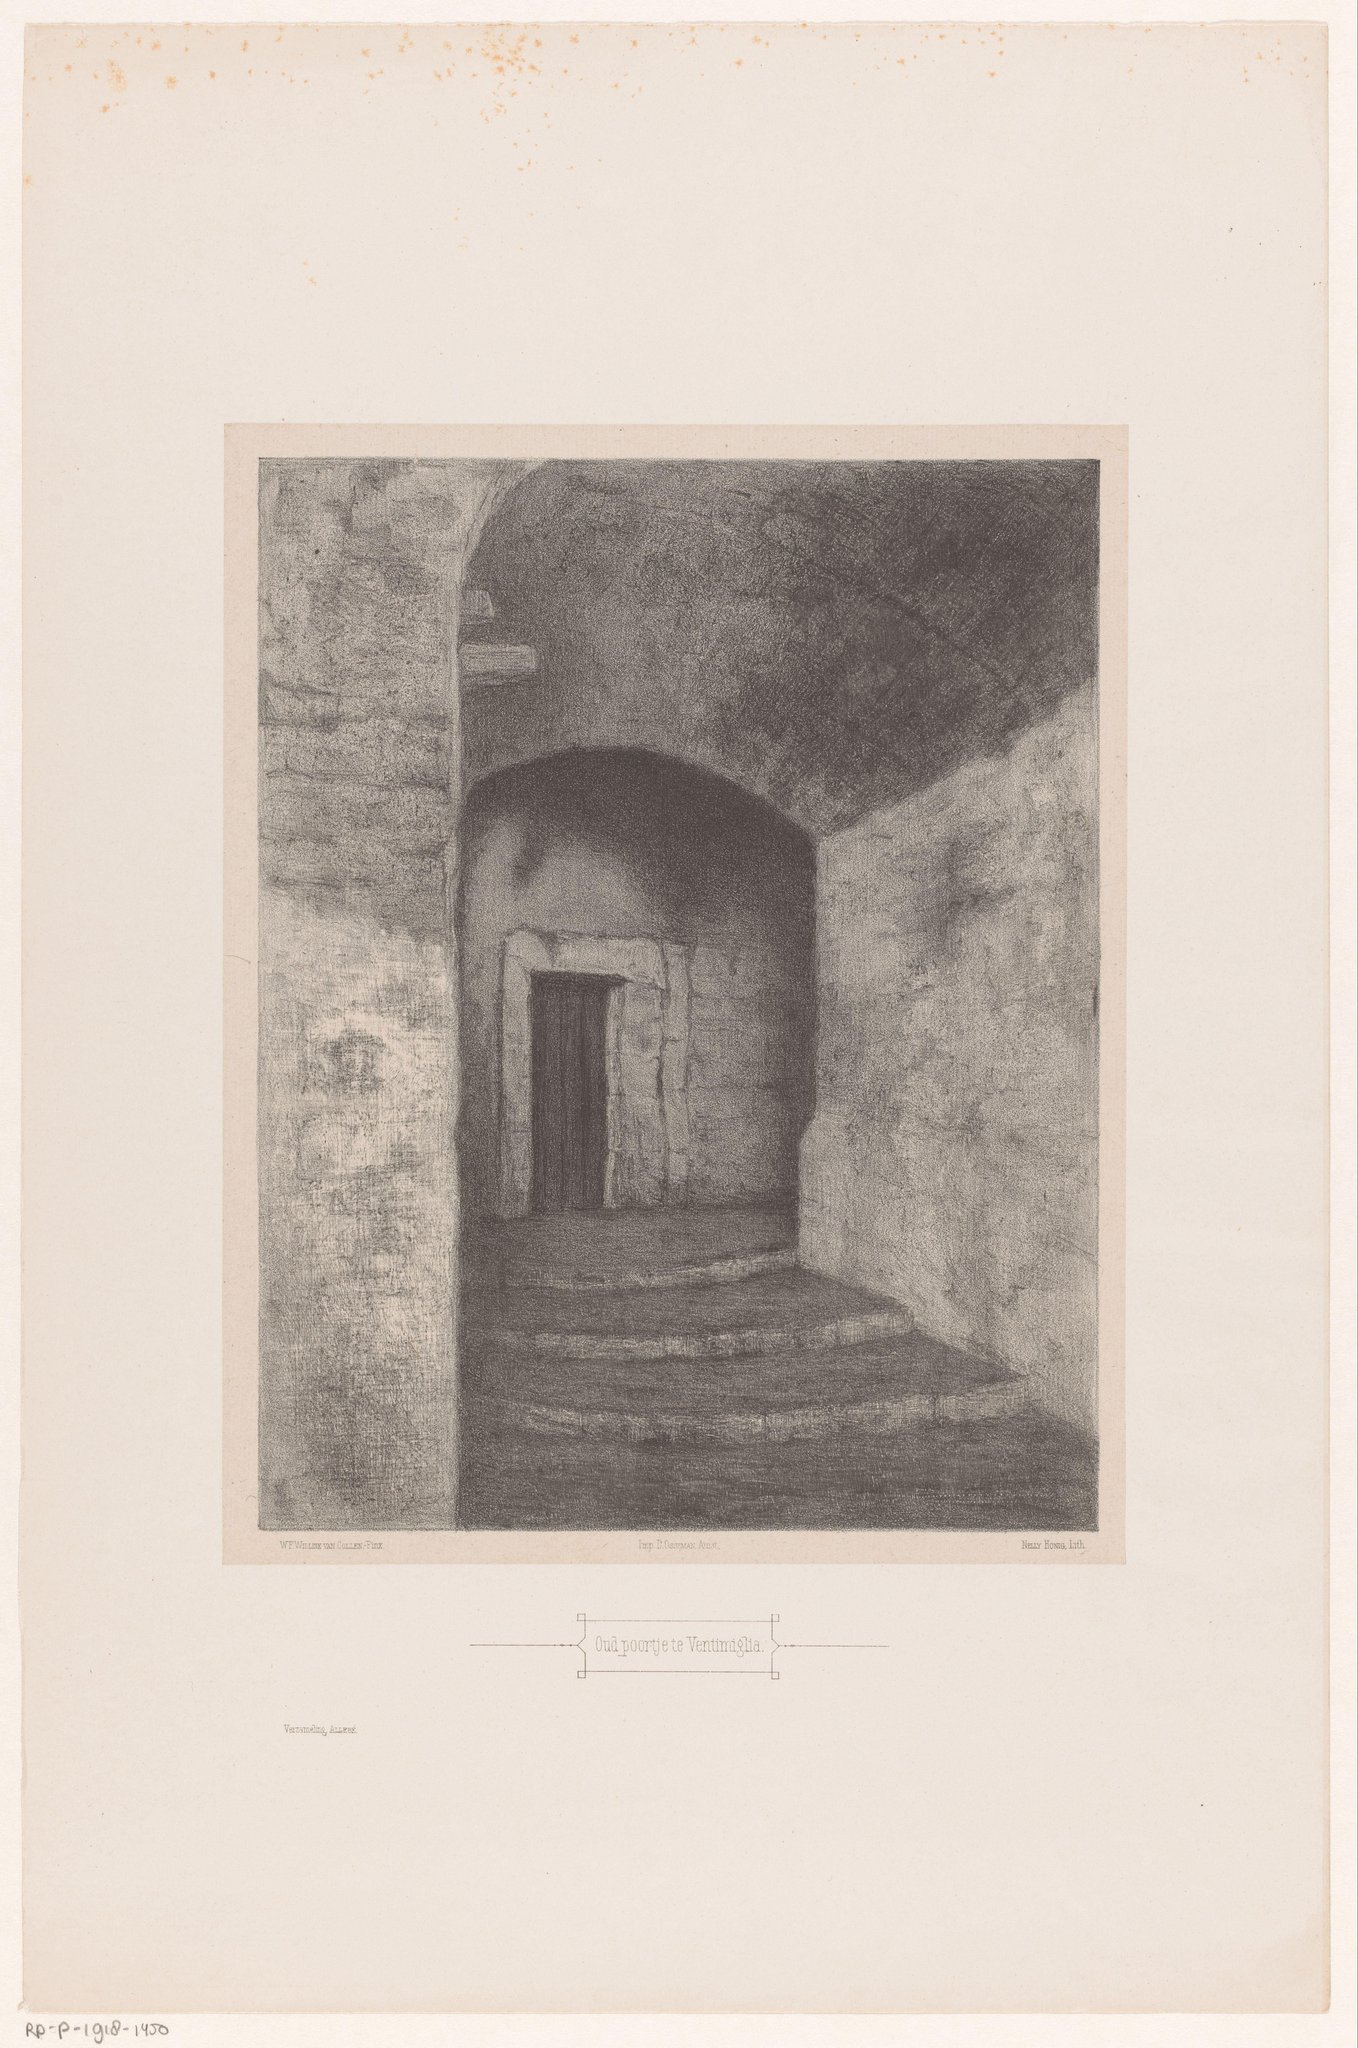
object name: print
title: Oude poort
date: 1889-1918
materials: paper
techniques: lithograph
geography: amsterdam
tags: gate, entrance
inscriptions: collector's mark: Lugt 2228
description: Aan het einde van een donkere steeg, bovenaan een trap, zit een houten deur.